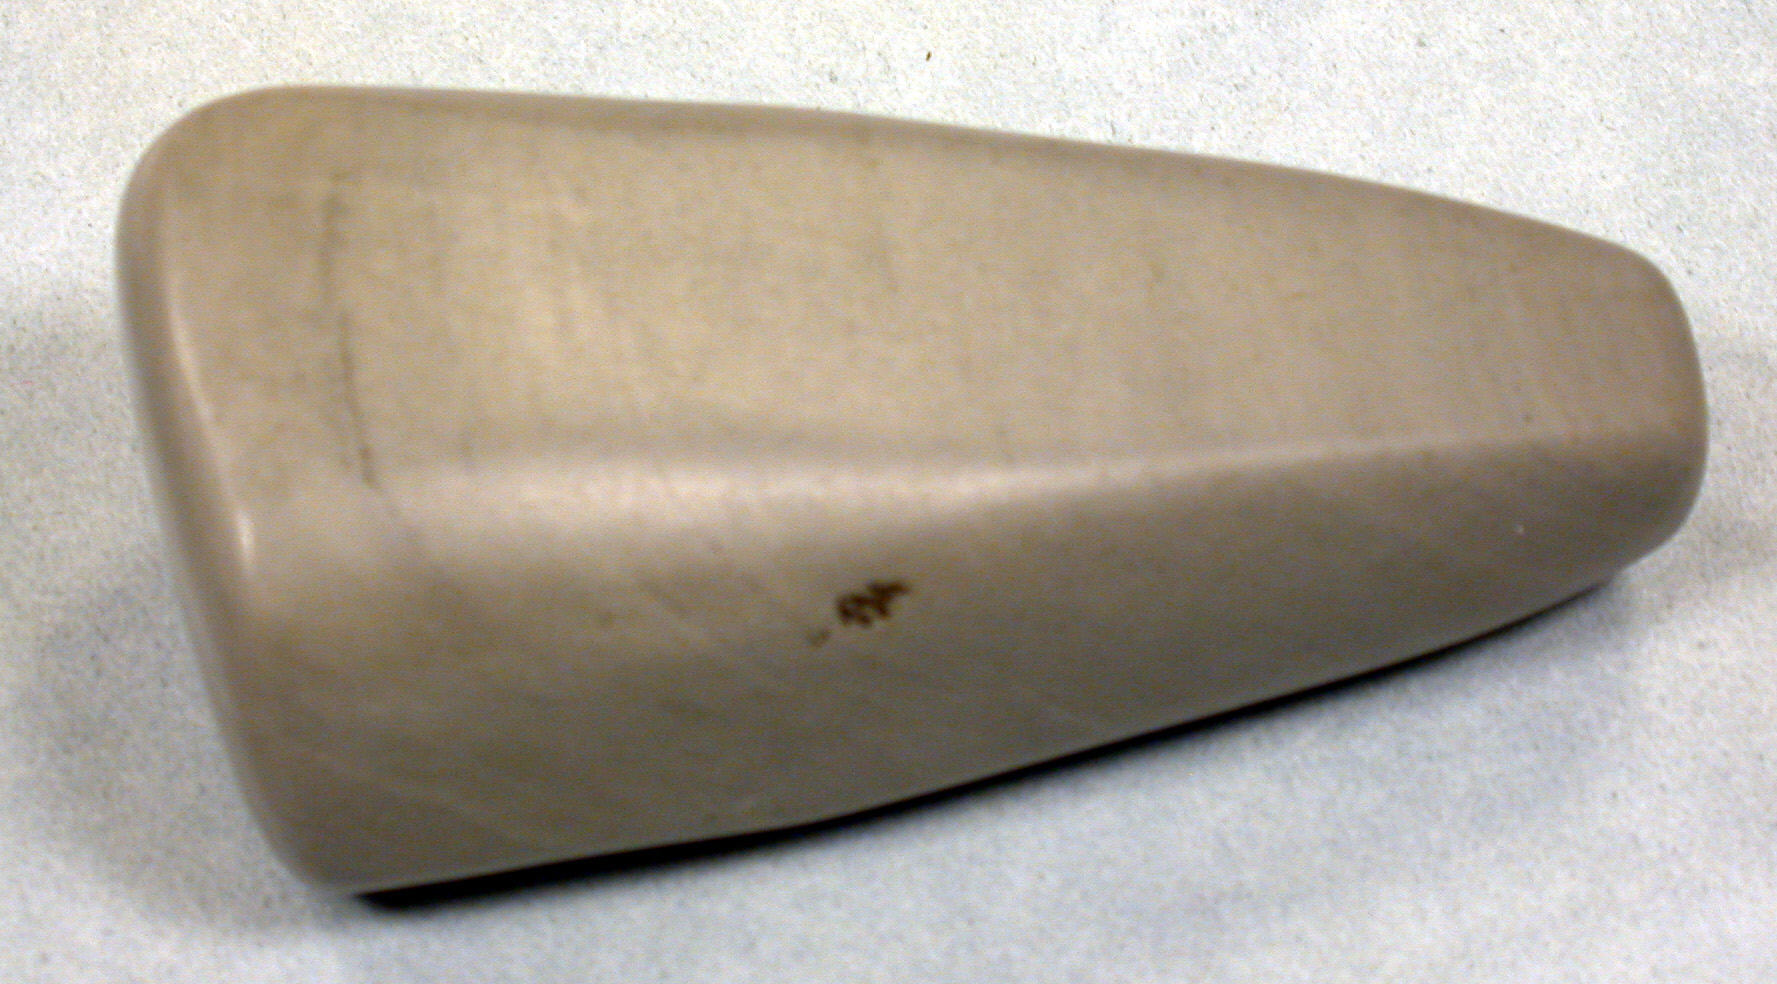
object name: ritual stone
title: Pulidor (polishing stone) (?)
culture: peruvian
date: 1501-1600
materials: stone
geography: peru